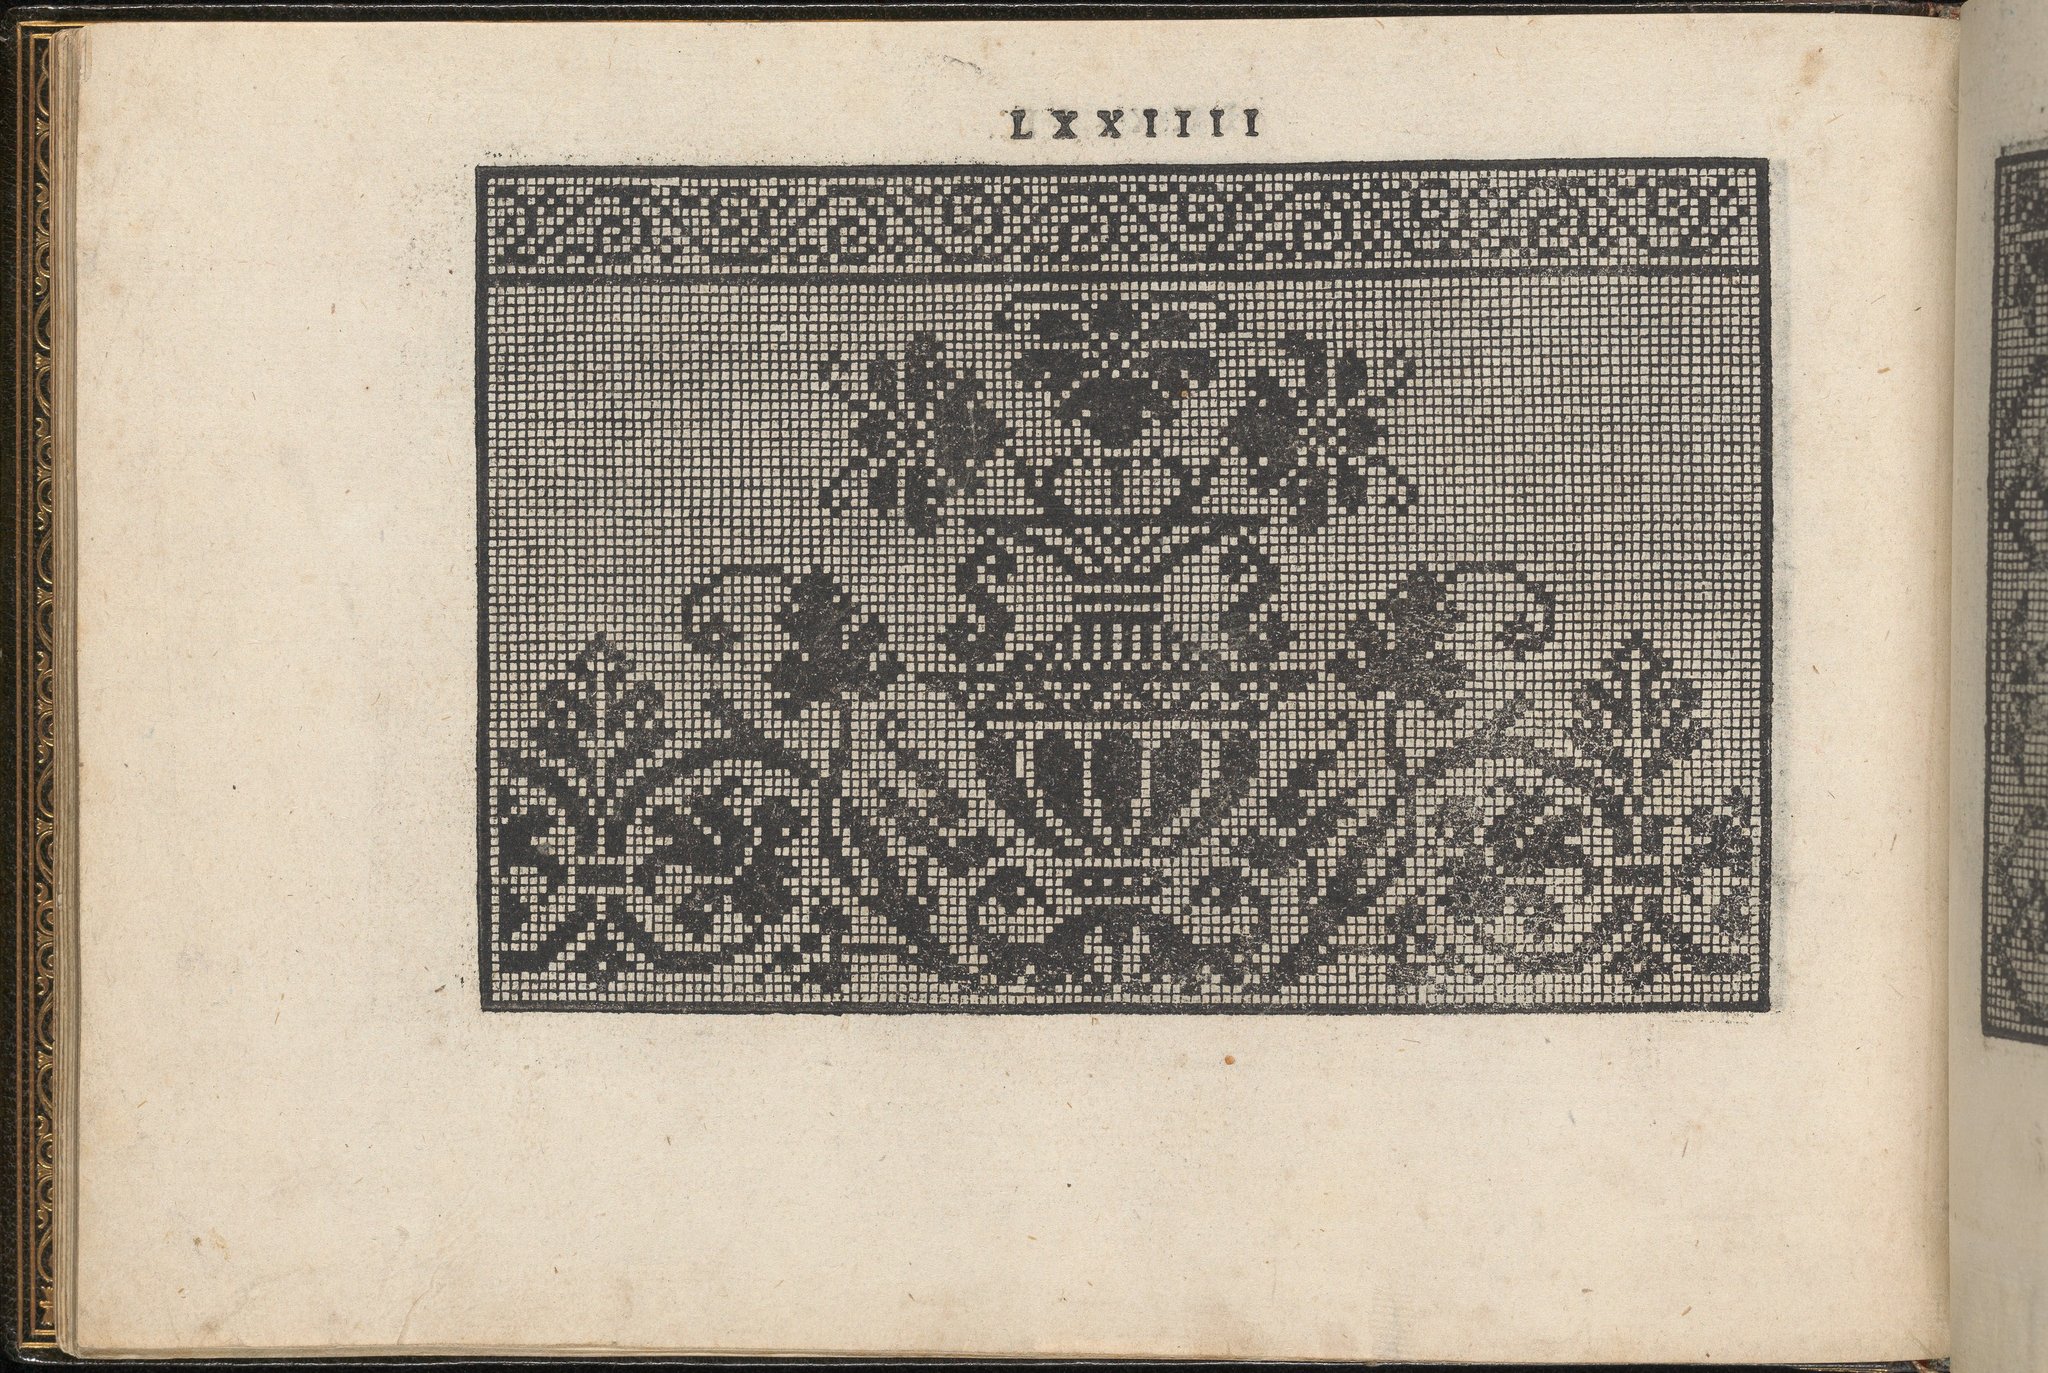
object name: book print ornament architecture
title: La Vera Perfettione del Disegno di varie sorti di recami, page 37 (verso)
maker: giovanni ostaus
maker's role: publisher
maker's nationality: italian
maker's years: 1507-1607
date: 1567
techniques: woodcut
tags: vases